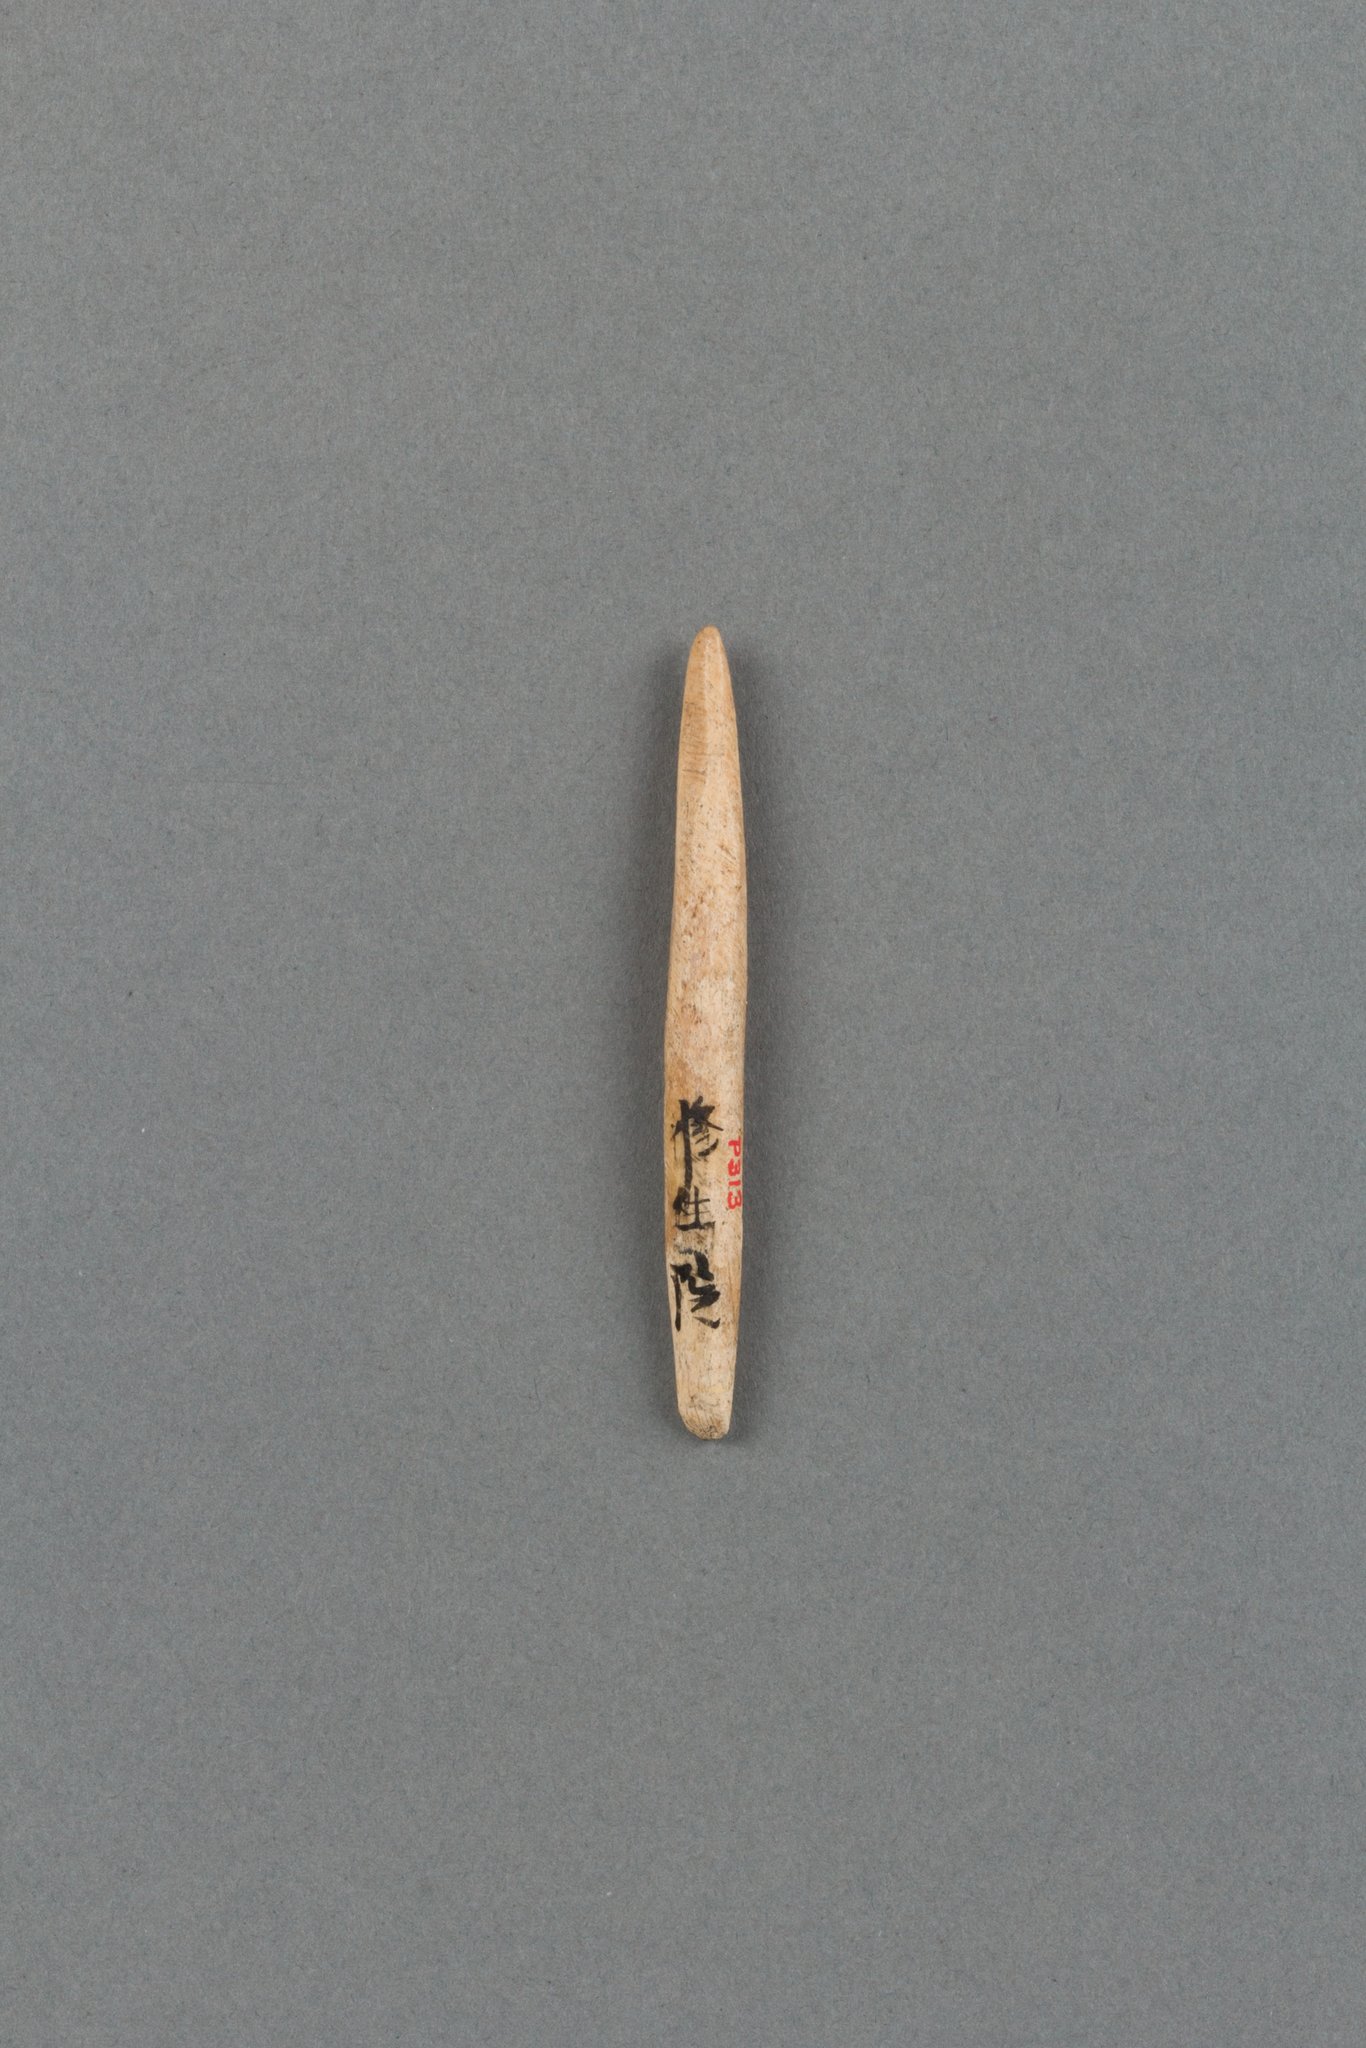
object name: harpoon head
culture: japanese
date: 1000-300 BCE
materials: bone